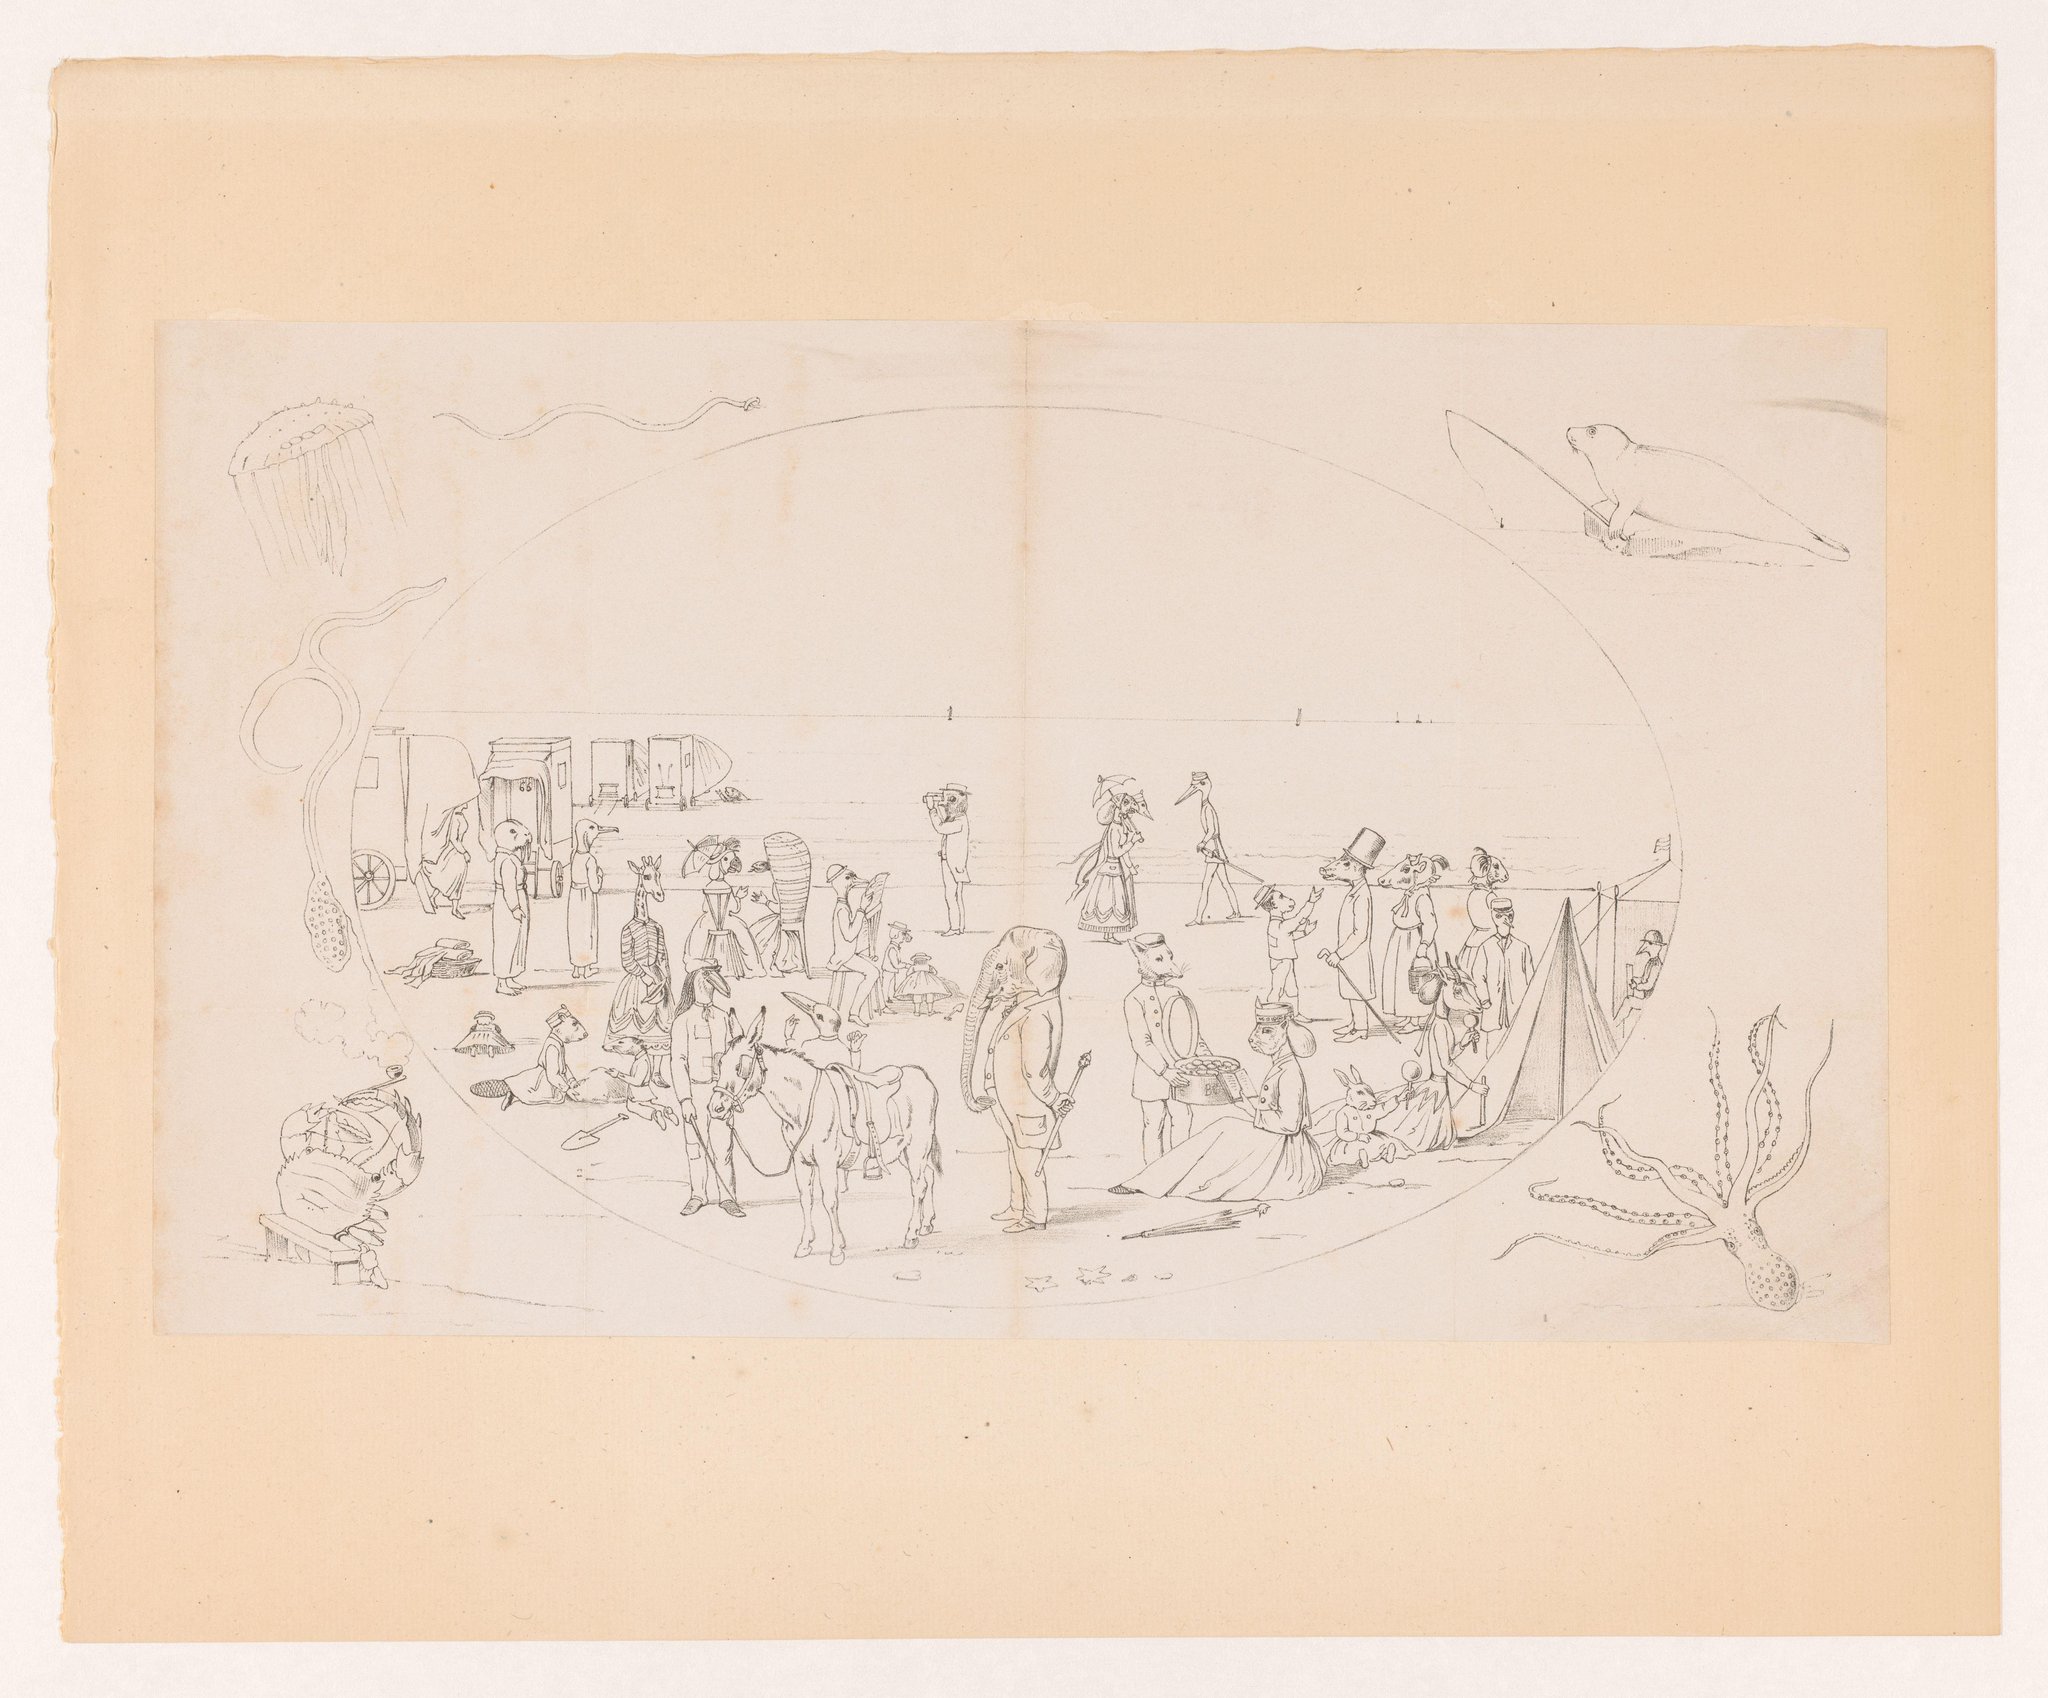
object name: print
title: Strandtafereel met dieren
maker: jonkheer victor eugène louis de stuers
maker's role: draughtsman, print maker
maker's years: 1843-1916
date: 1853-1916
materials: paper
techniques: lithograph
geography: netherlands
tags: animals acting as human beings, beach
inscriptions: collector's mark: Lugt 2760, collector's mark: Lugt 2228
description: Dieren in menselijke gedaanten recreëren op een strand. In een omlijsting met vier zeedieren.